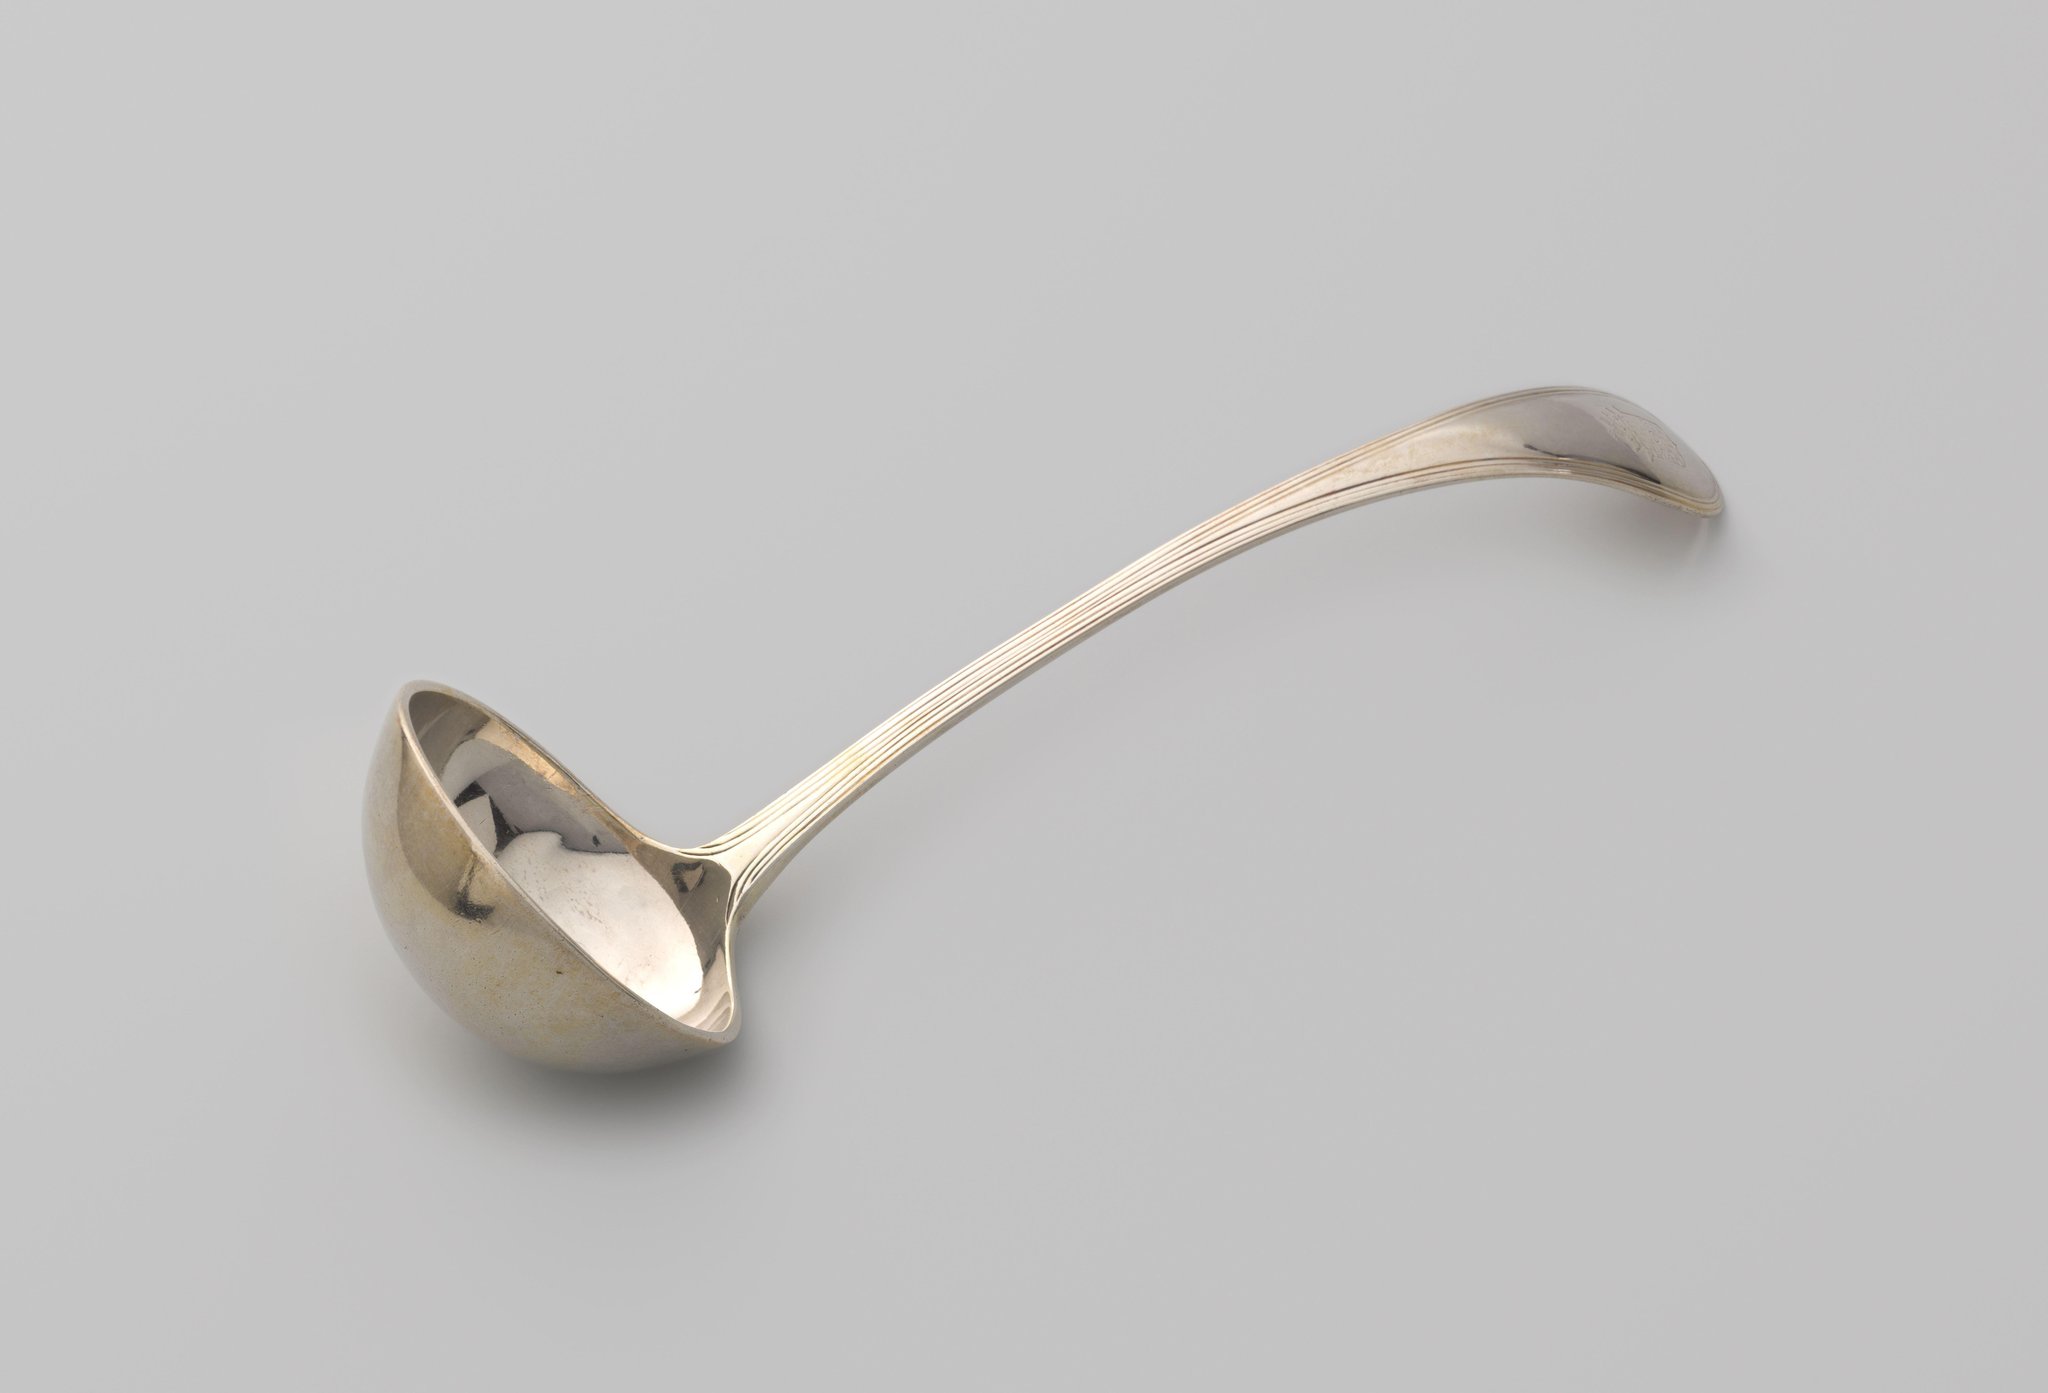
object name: spoon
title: Soeplepel met het familiewapen Clifford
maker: nathanael teuter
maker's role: silversmith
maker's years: 1767-1831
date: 1823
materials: silver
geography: amsterdam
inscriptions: maker's mark, date letter: ‘O’, assay office mark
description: De ronde, diepe bak is door middel van enkel lof verbonden met de platte, krachtig gebogen steel, die zich verbreedt naar het afgeronde uiteinde en die aan de bovenzijde omgeven wordt door een filetrand. Op de bovenzijde van de steel is het gekroonde wapen Clifford met het helmteken en schildhouders gegraveerd.